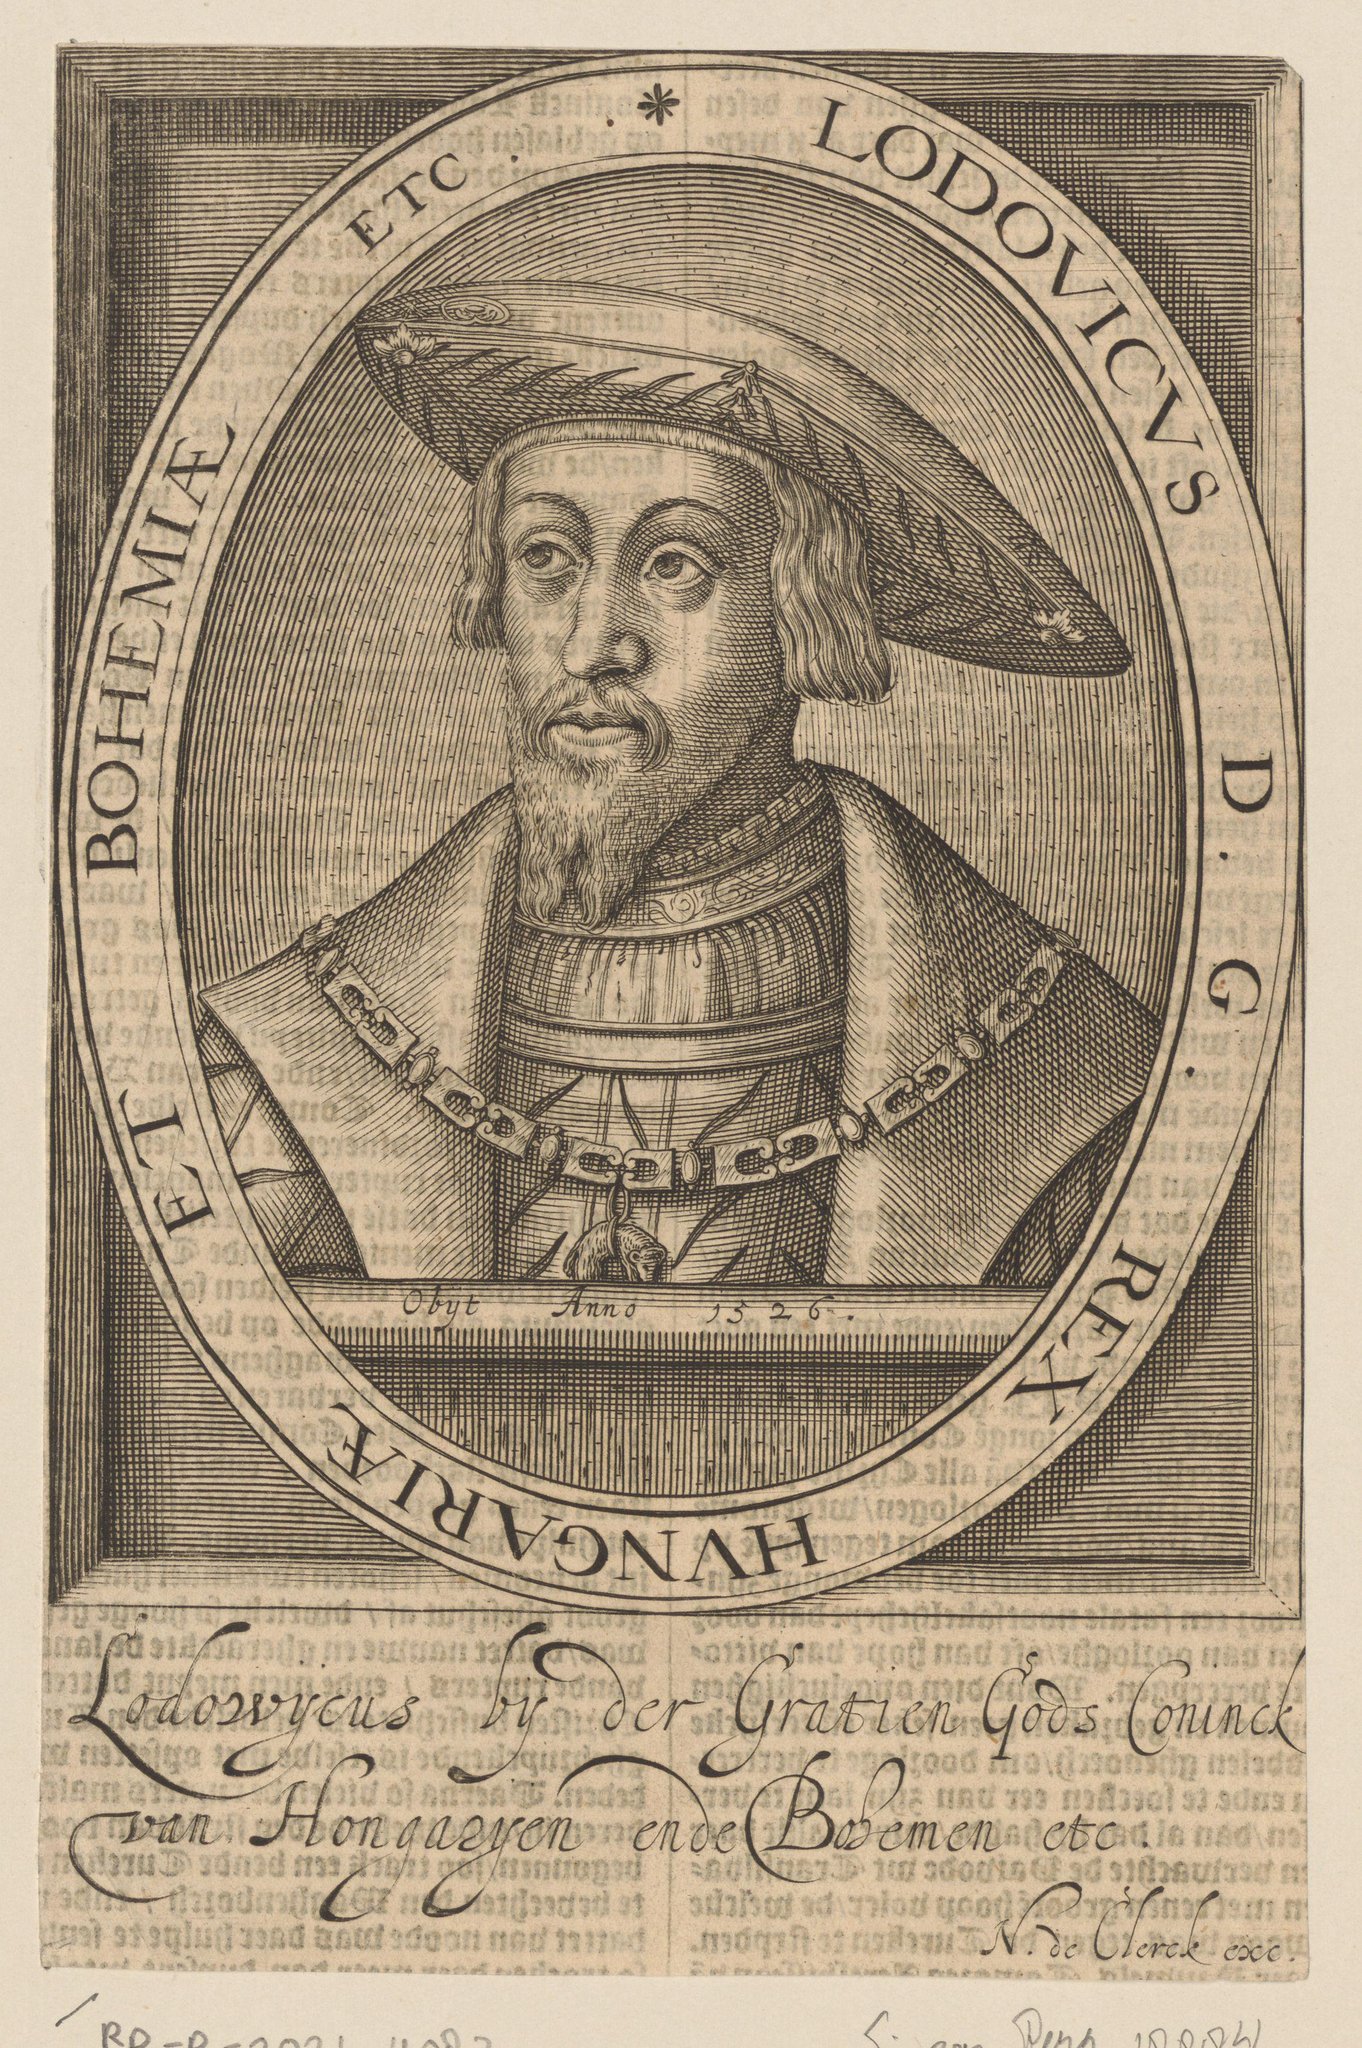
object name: book illustration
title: Portret van Lodewijk II van Hongarije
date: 1610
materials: paper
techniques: engraving, letterpress printing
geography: delft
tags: ornament ~ medallion, historical persons, knighthood order of the golden fleece - insignia of a knighthood order, e.g.: badge, chain (with name of order)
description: Prent uit: Ulloa, Alfonso de. Historie, ende het leven van den Aldermachtichsten ende victorieusten keyser Caerle de vijfde (...). Delft: Adriaen Gerritsz, 1610.